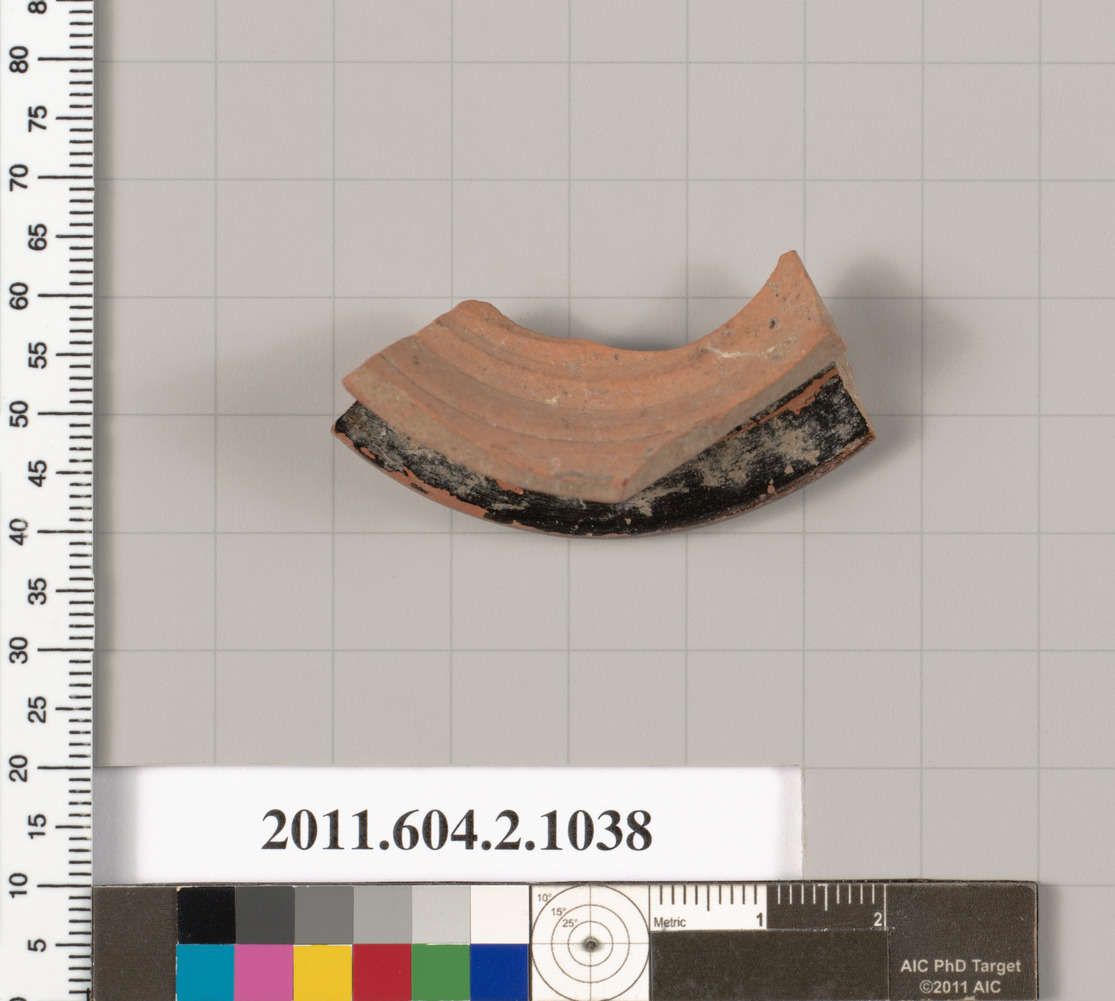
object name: oinochoe fragment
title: Terracotta fragment of an oinochoe (jug)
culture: greek, attic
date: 450-401 BCE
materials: terracotta